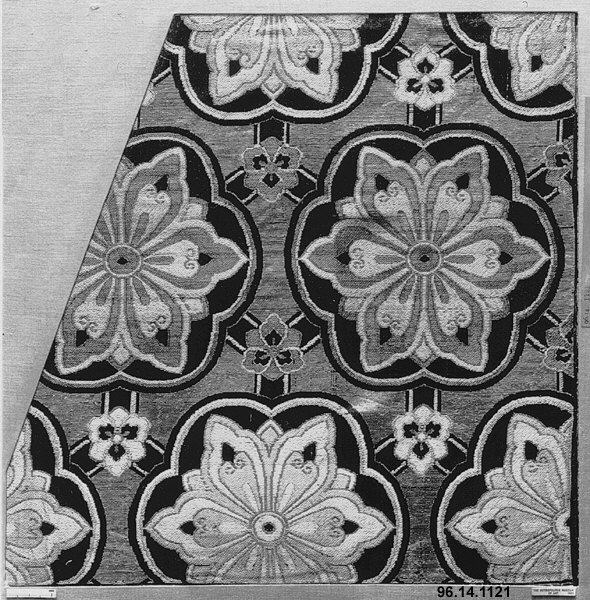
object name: piece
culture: japanese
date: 1701-1900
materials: silk